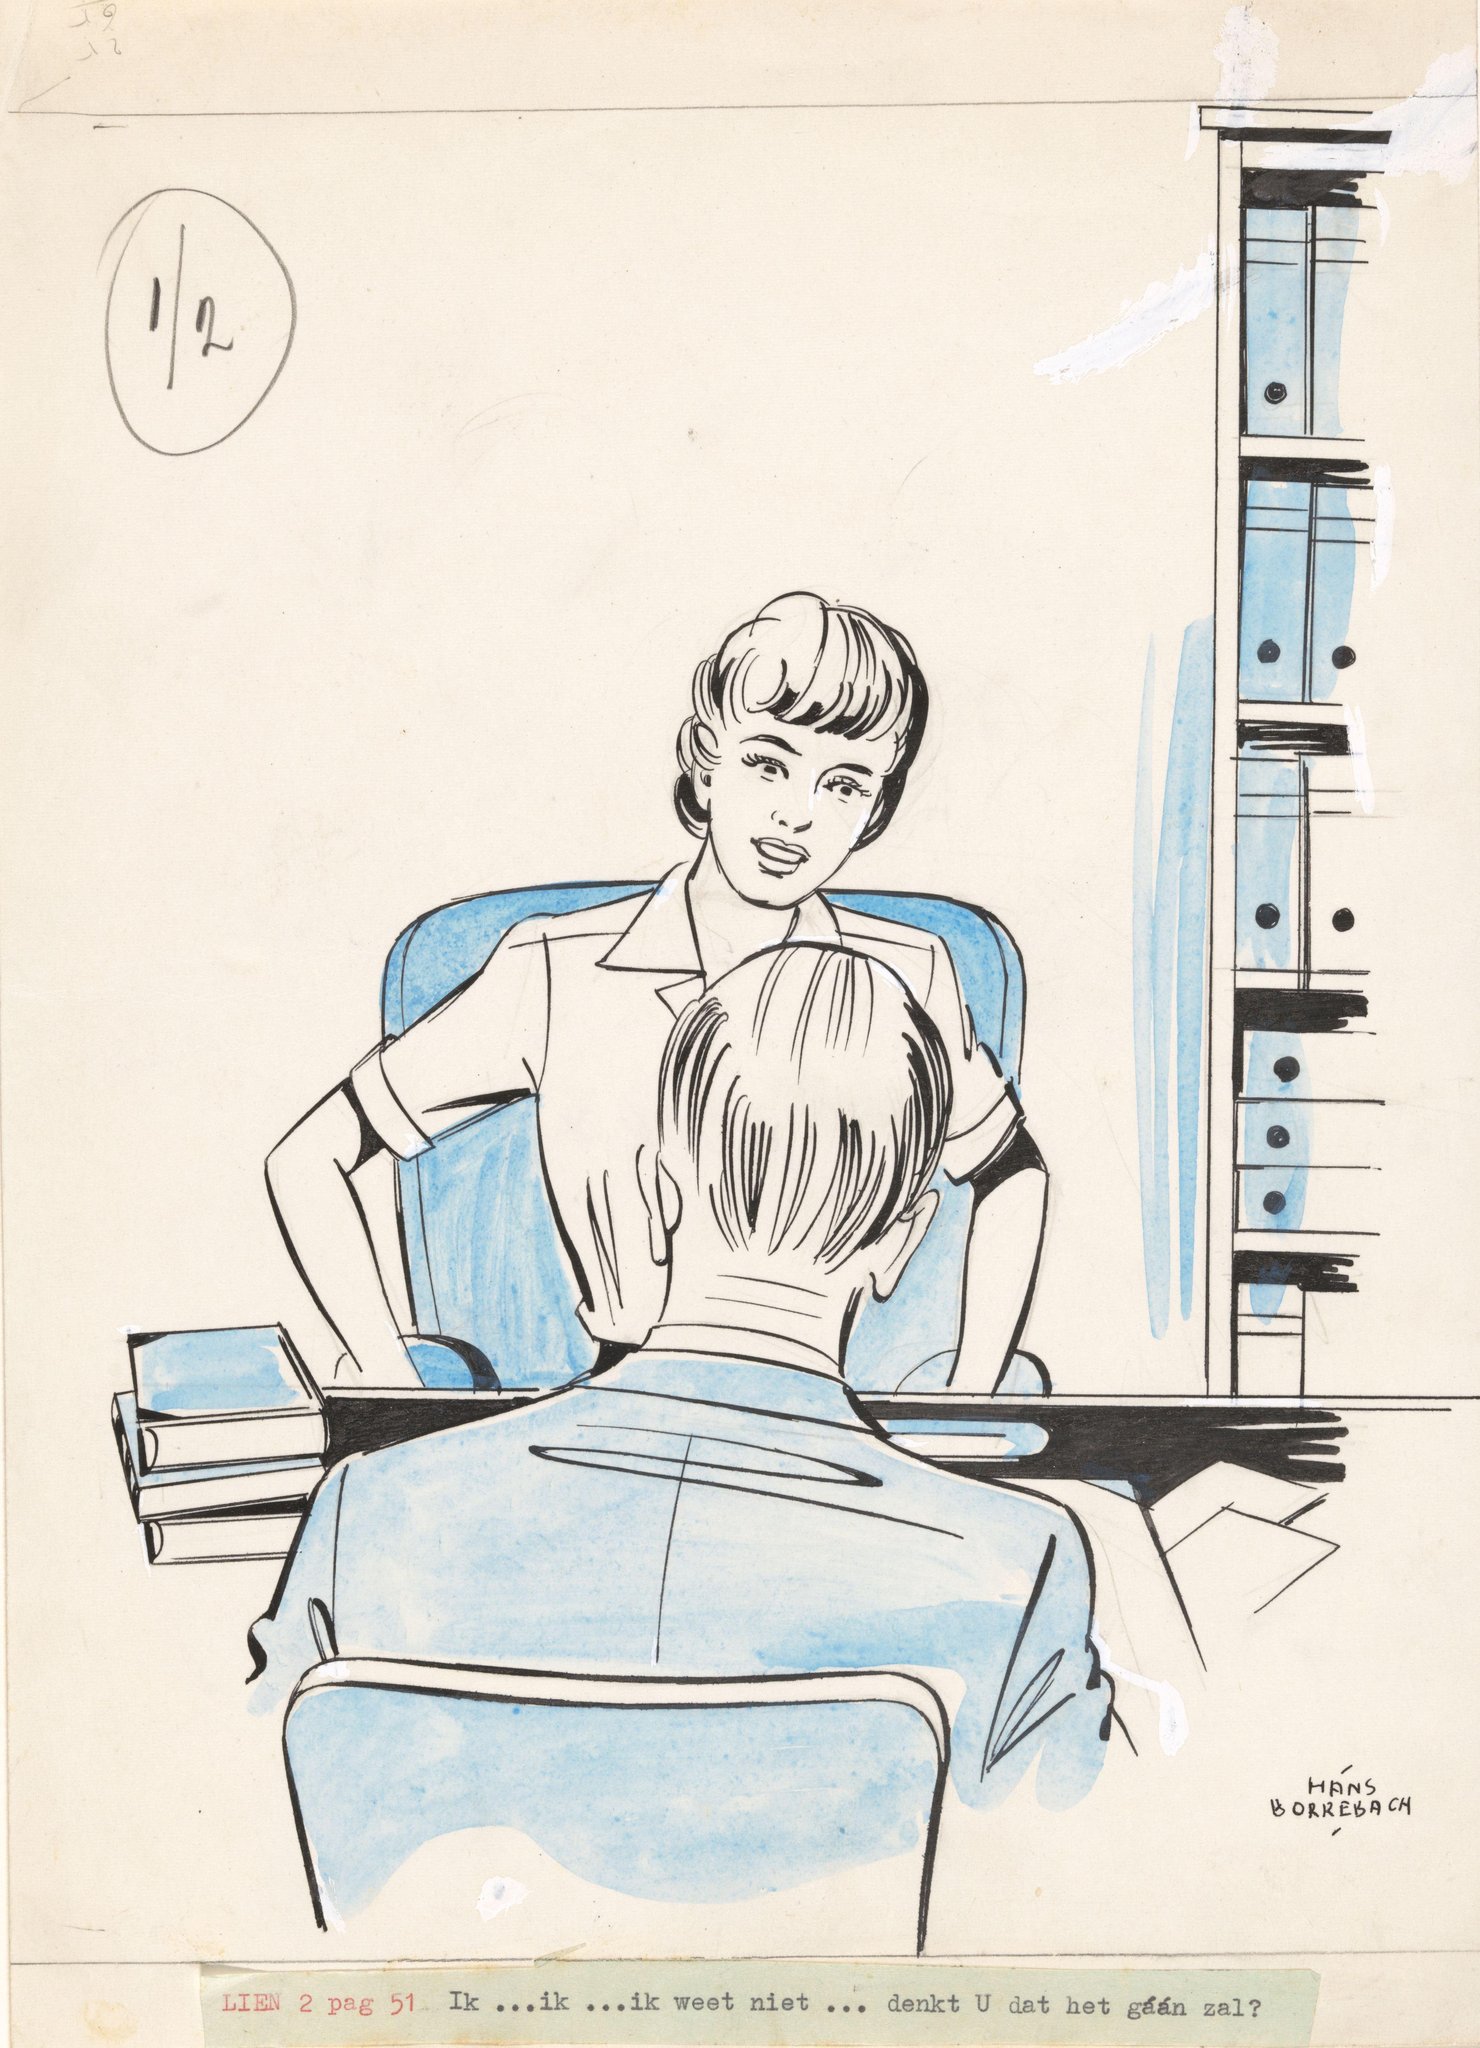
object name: boekillustratie ontwerp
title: Lien zit aan een bureau tegenover een man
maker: hans borrebach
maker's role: draughtsman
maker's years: 1903-1991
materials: paint, ink, paper, pencil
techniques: brush, pen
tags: writing-table, writing-desk, adolescent, young woman, maiden, conversation, dialogue; conversation piece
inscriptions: :, annotation: ‘LIEN 2 pag 51 Ik ...ik...ik weet het niet... denkt U dat het gáán zal?’, collector's mark: Lugt 2228a, signature: ‘HANS/ BORREBACH’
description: In een ruimte waarin een kast met archiefdozen staat zit Lien tegenover een man aan een bureau. Op het bureau liggen boeken en papieren.